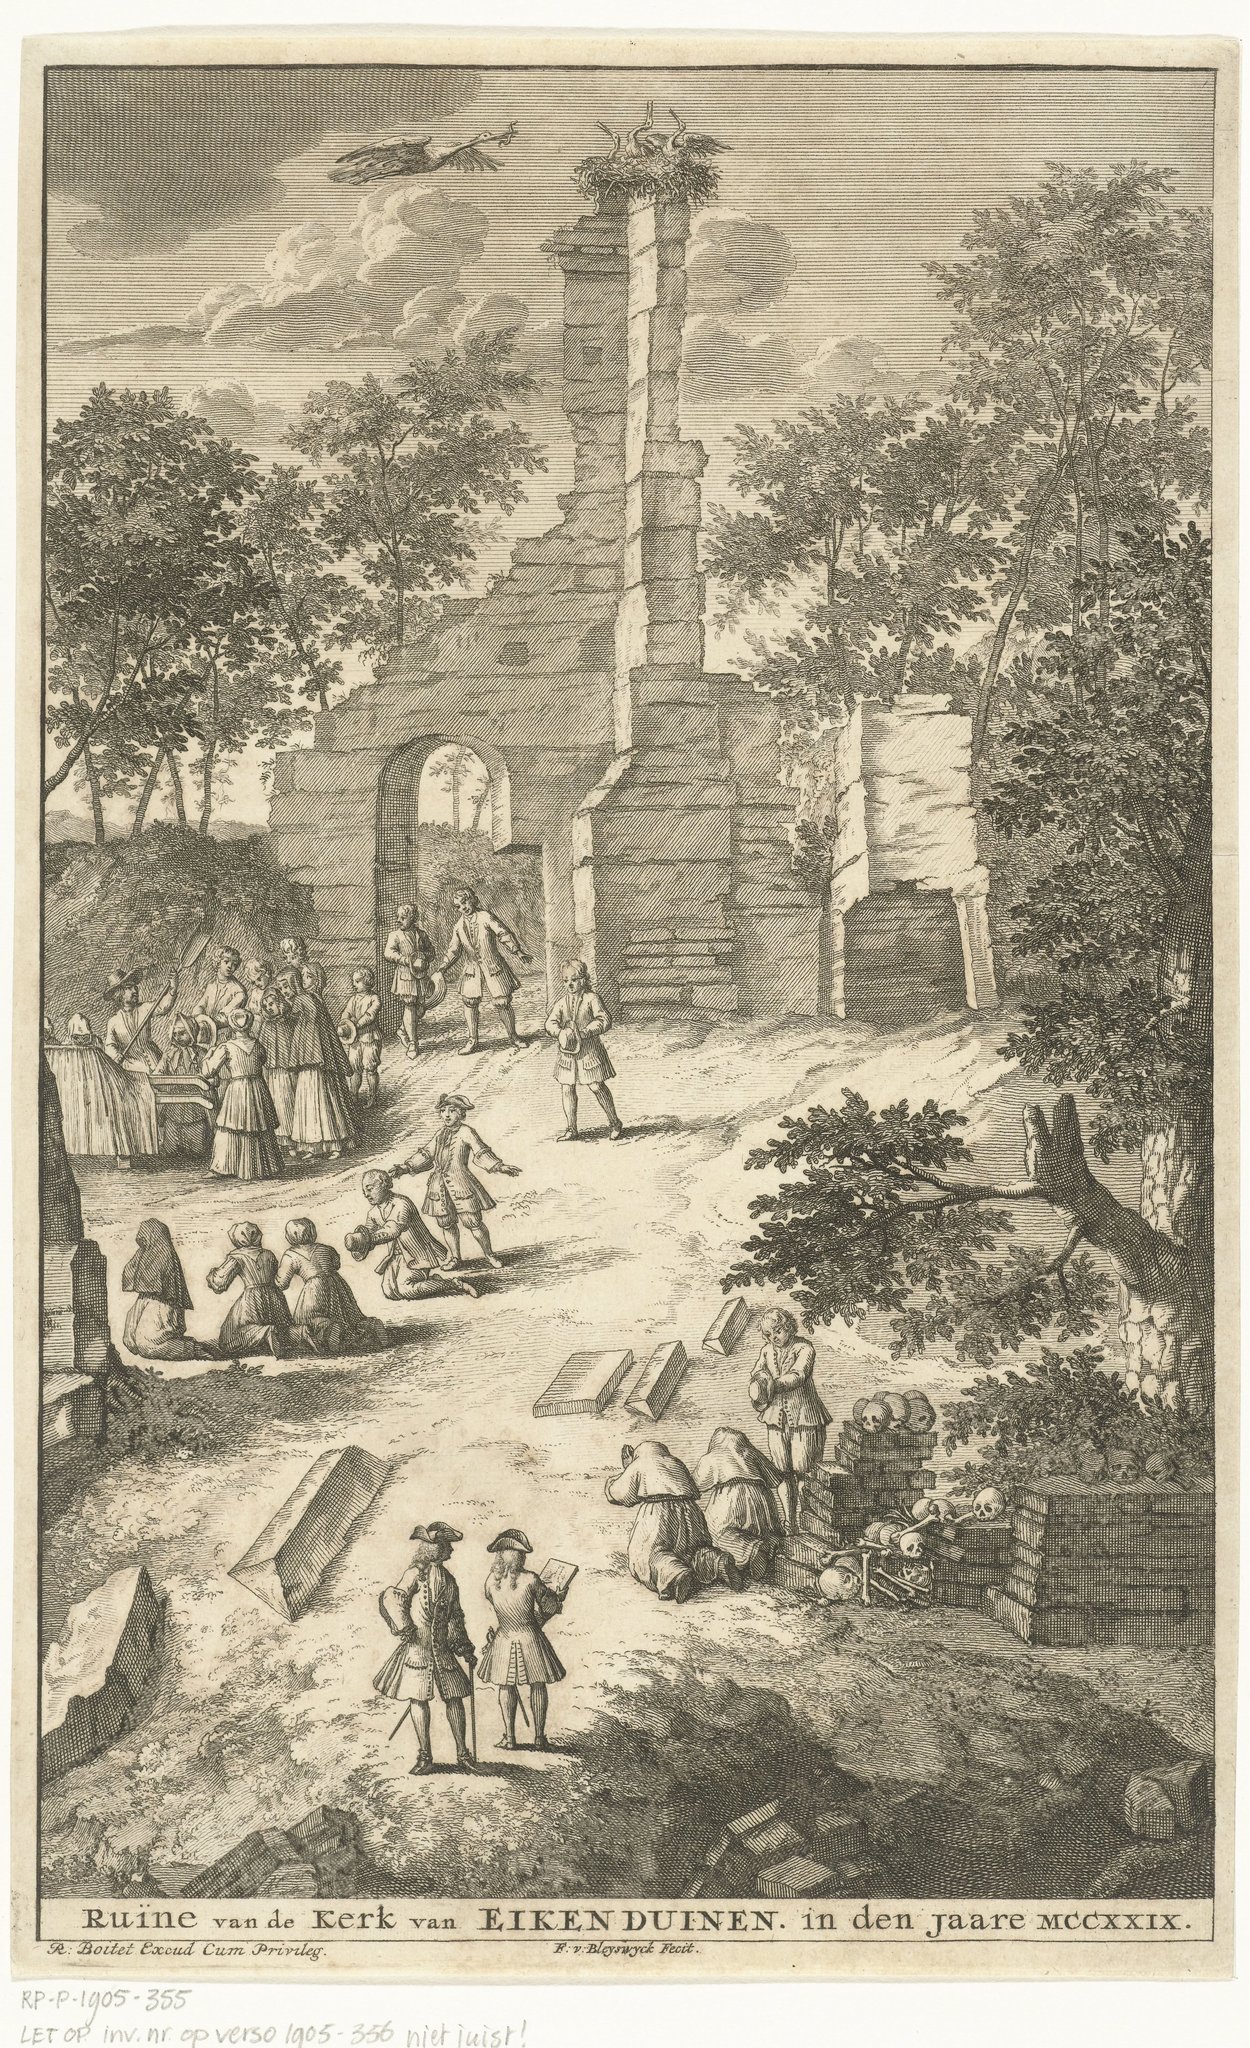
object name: book illustration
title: Gezicht op de ruïne van de kerk van Eik en Duinen, 1729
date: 1729-1736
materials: paper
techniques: engraving, etching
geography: leiden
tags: burial, shore-birds and wading-birds: stork, pilgrim(s), ruin of church, monastery, etc.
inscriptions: collector's mark: Lugt 2228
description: Gezicht op de ruïne van de in 1580 gesloopte kerk van Eik en Duinen, een voormalig gehucht gelegen in de duinen tussen Loosduinen en Den Haag, in het jaar 1729. De plek wordt bezocht door pelgrims en er vindt een begrafenis plaats. Op de resten van de kerktoren heeft een ooievaar een nest gemaakt en worden drie jongen gevoed.